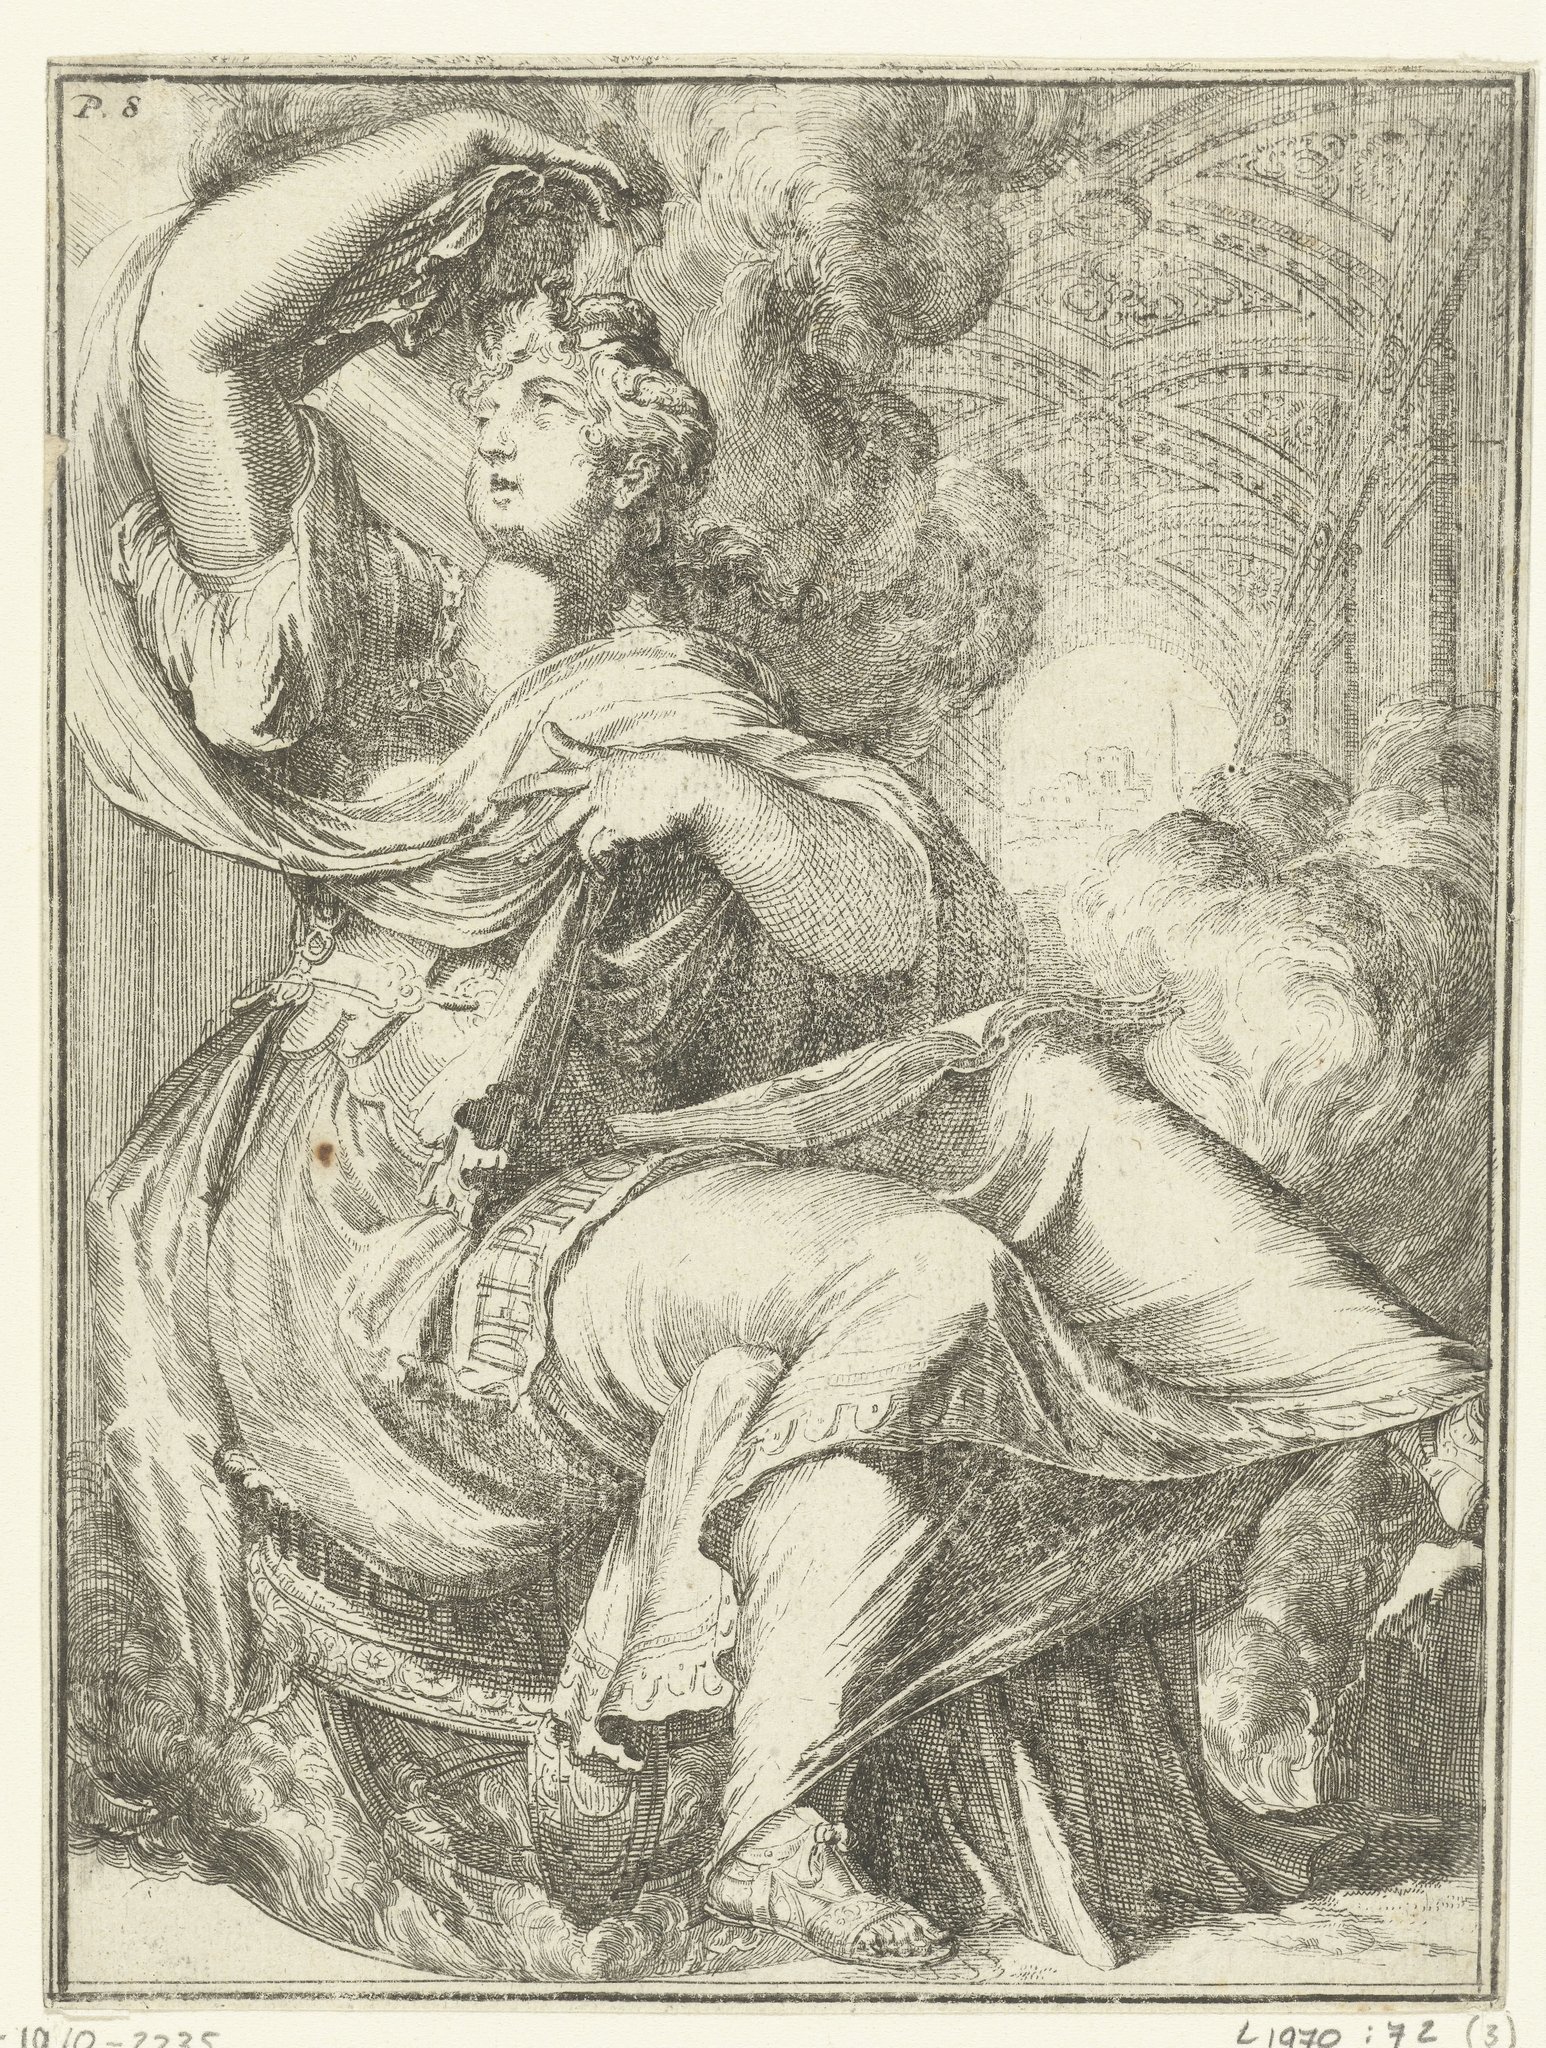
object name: print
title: S Delphica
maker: romeyn de hooghe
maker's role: draughtsman, goldsmith, painter, print maker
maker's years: 1645-1708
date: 1688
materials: paper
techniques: engraving, etching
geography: netherlands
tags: sibyls (with name)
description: Illustratie voor: Servatius Gallaeus, Dissertationes de Sibyllis, earumque oraculis, Amsterdam, Dirk en Hendrik Boom, 1688, p. 87.